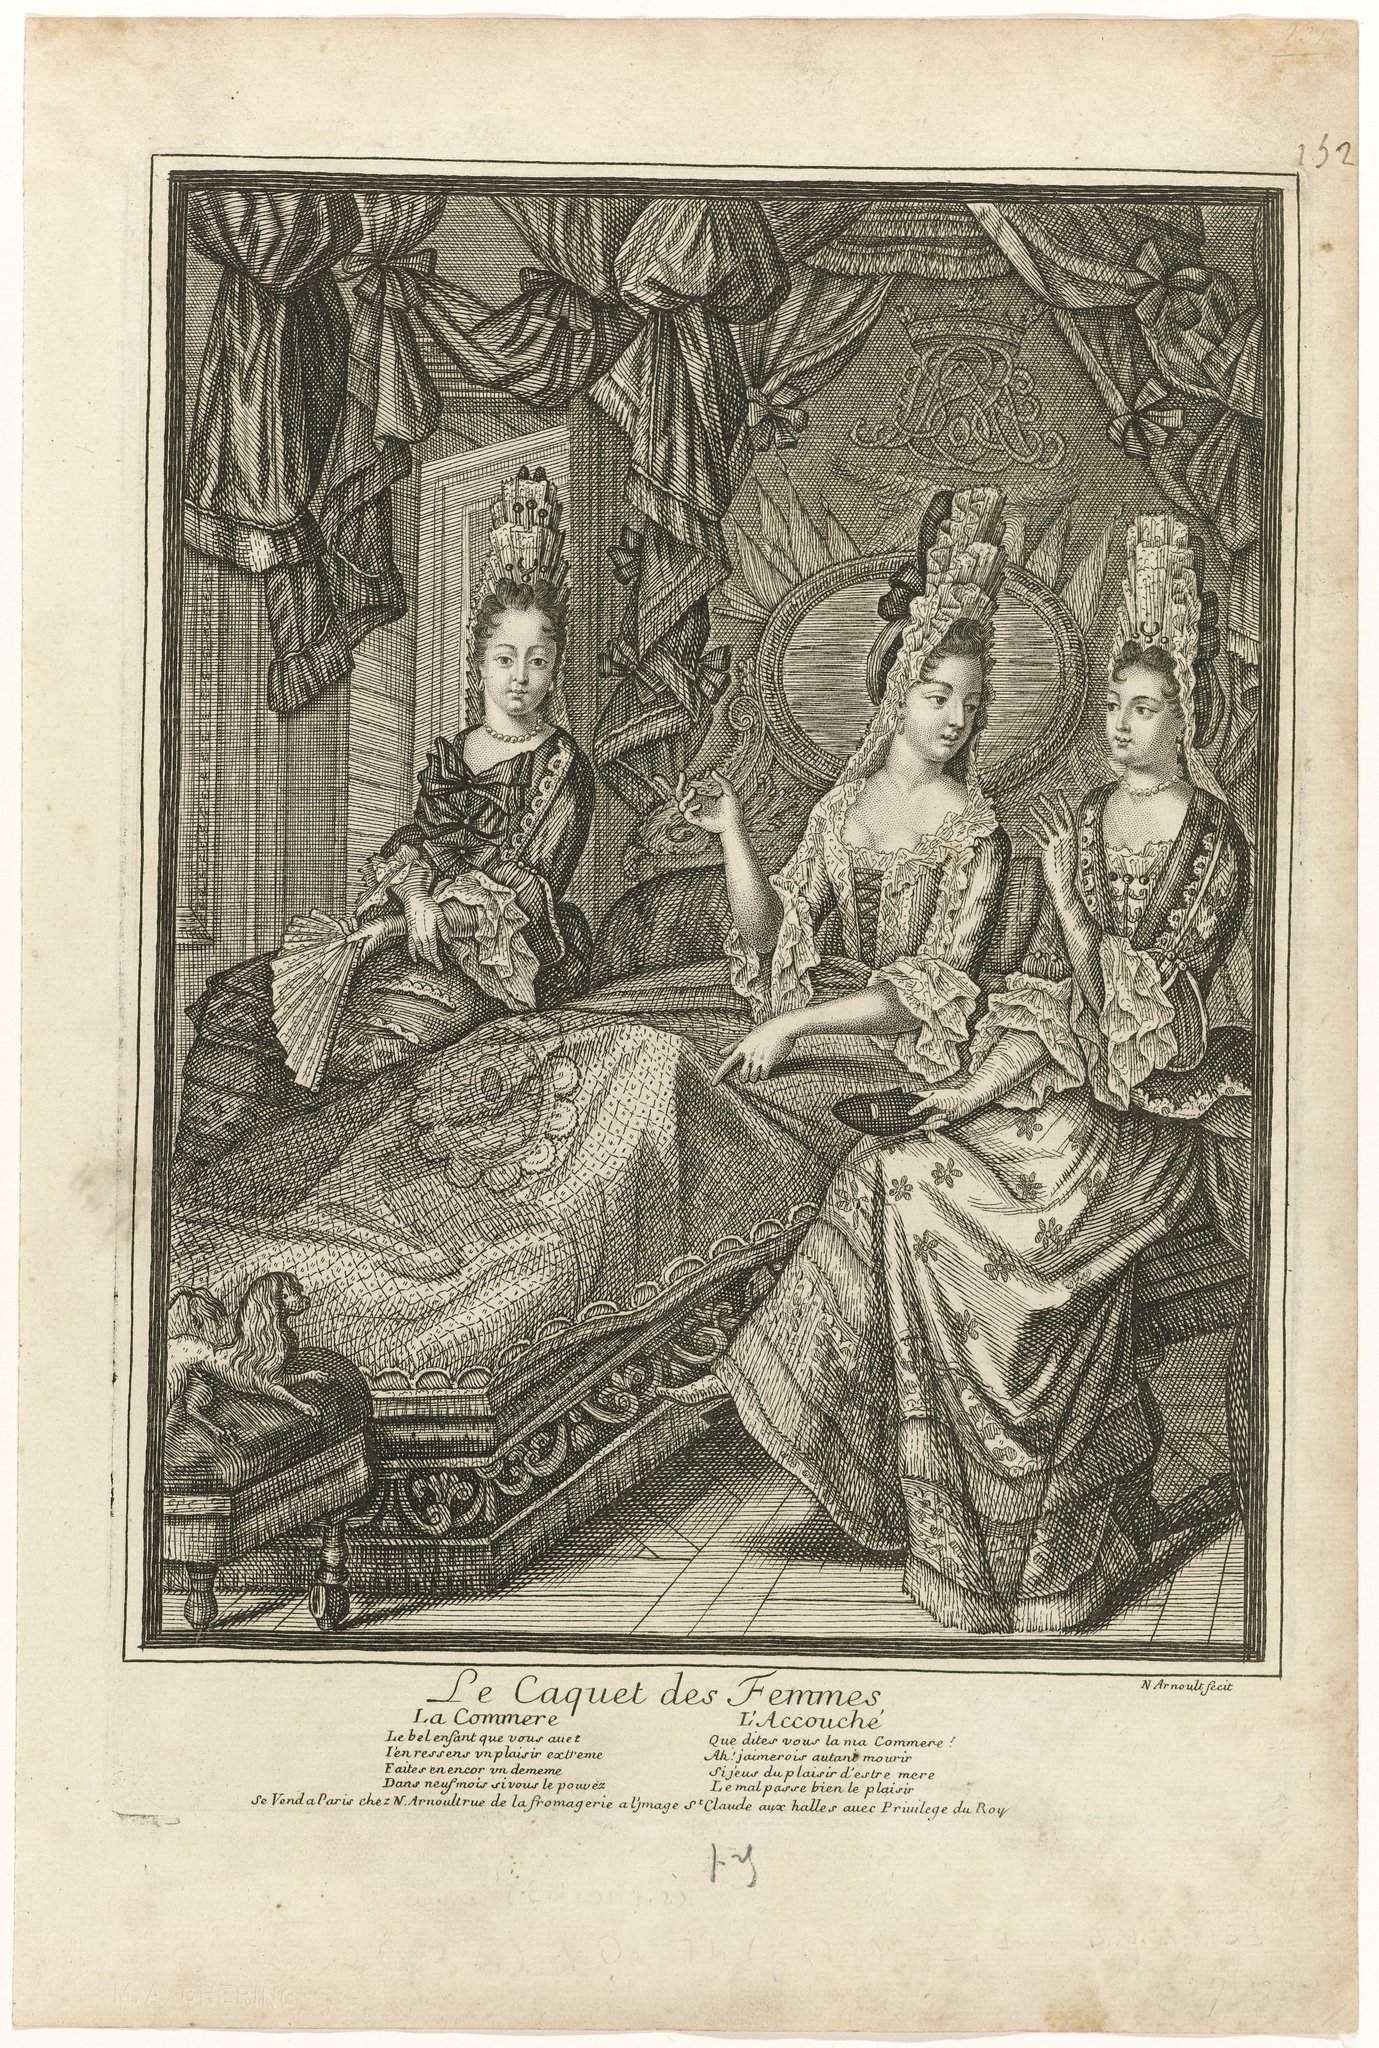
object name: costume print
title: Le Caquet des femmes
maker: nicolas arnoult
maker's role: print maker, publisher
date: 1682-1722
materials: paper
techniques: engraving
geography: paris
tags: gloves, mittens (long gloves) (+ women's clothes), black velvet or satin mask, 'loup', 'cachenez' (+ women's clothes), piece of clothing covering the breast or décolleté (stomacher) (+ women's clothes), styles of hairdress - aa - ~ women, skirt (+ women's clothes), bed, head-gear: fontange (+ women's clothes), fan (+ women's clothes), dress, gown: manteau (+ women's clothes), pearl; pearl necklace (+ women's clothes)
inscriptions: caption: ‘La Commere: Le bel enfant que vous avez / I'en ressens un plaisir extreme / Faites en encor un dememe / Dans neuf mois si vous le pouvez / l'Accouché: Que dites vous la ma Commere ! / Ah! jaimerois autant mourir / Si jeus de plaisir d'estre mere / Le mal passe bien le plaisir.’, title: ‘Le Caquet des Femmes’, privilege: ‘Se Vend a Paris chez N. Arnoult rue de la fromagerie a l'image St Claude aux halles avec Privililege du Roy’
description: Drie vrouwen in een slaapkamer, pratend over de baby die door de middelste vrouw wordt verwacht. Alledrie dragen zij het modieuze fontangekapsel en zijn ze gekleed in een 'manteau' met engageantes. De vrouw links draagt als accessoires: oorbellen, een kralencollier (parelcollier), lange handschoenen en een waaier. De vrouw rechts draagt de manteau over een borststuk ('devant-de-gorge') en een rok met bloempatroon en falbala's. Ze draagt dezelfde sieraden en heeft een stoffen maskertje in de hand.